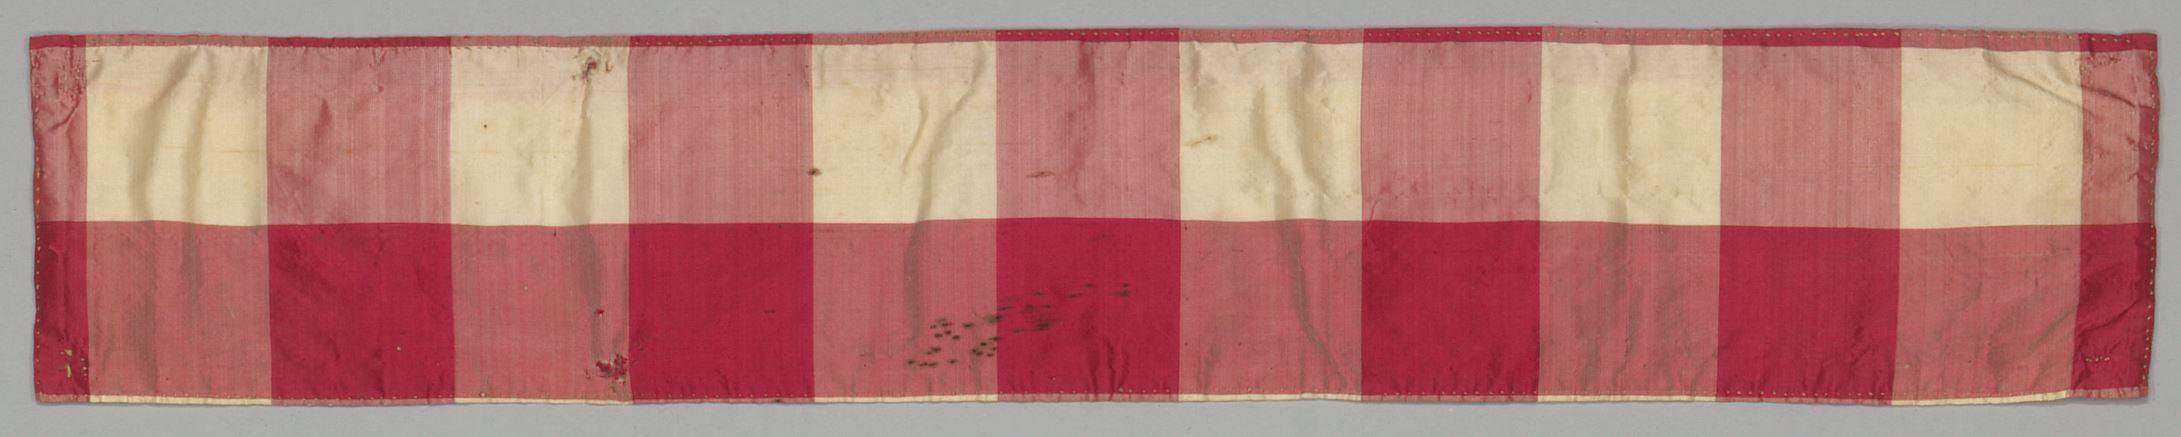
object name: tieback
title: Embrasse van rood-wit geblokte zijde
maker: Anonymous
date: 1776-1800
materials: linen, silk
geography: northern netherlands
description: Embrasse van rood-wit geblokte zijde, gevoerd met wit linnen en met twee stel metalen haken en ogen.